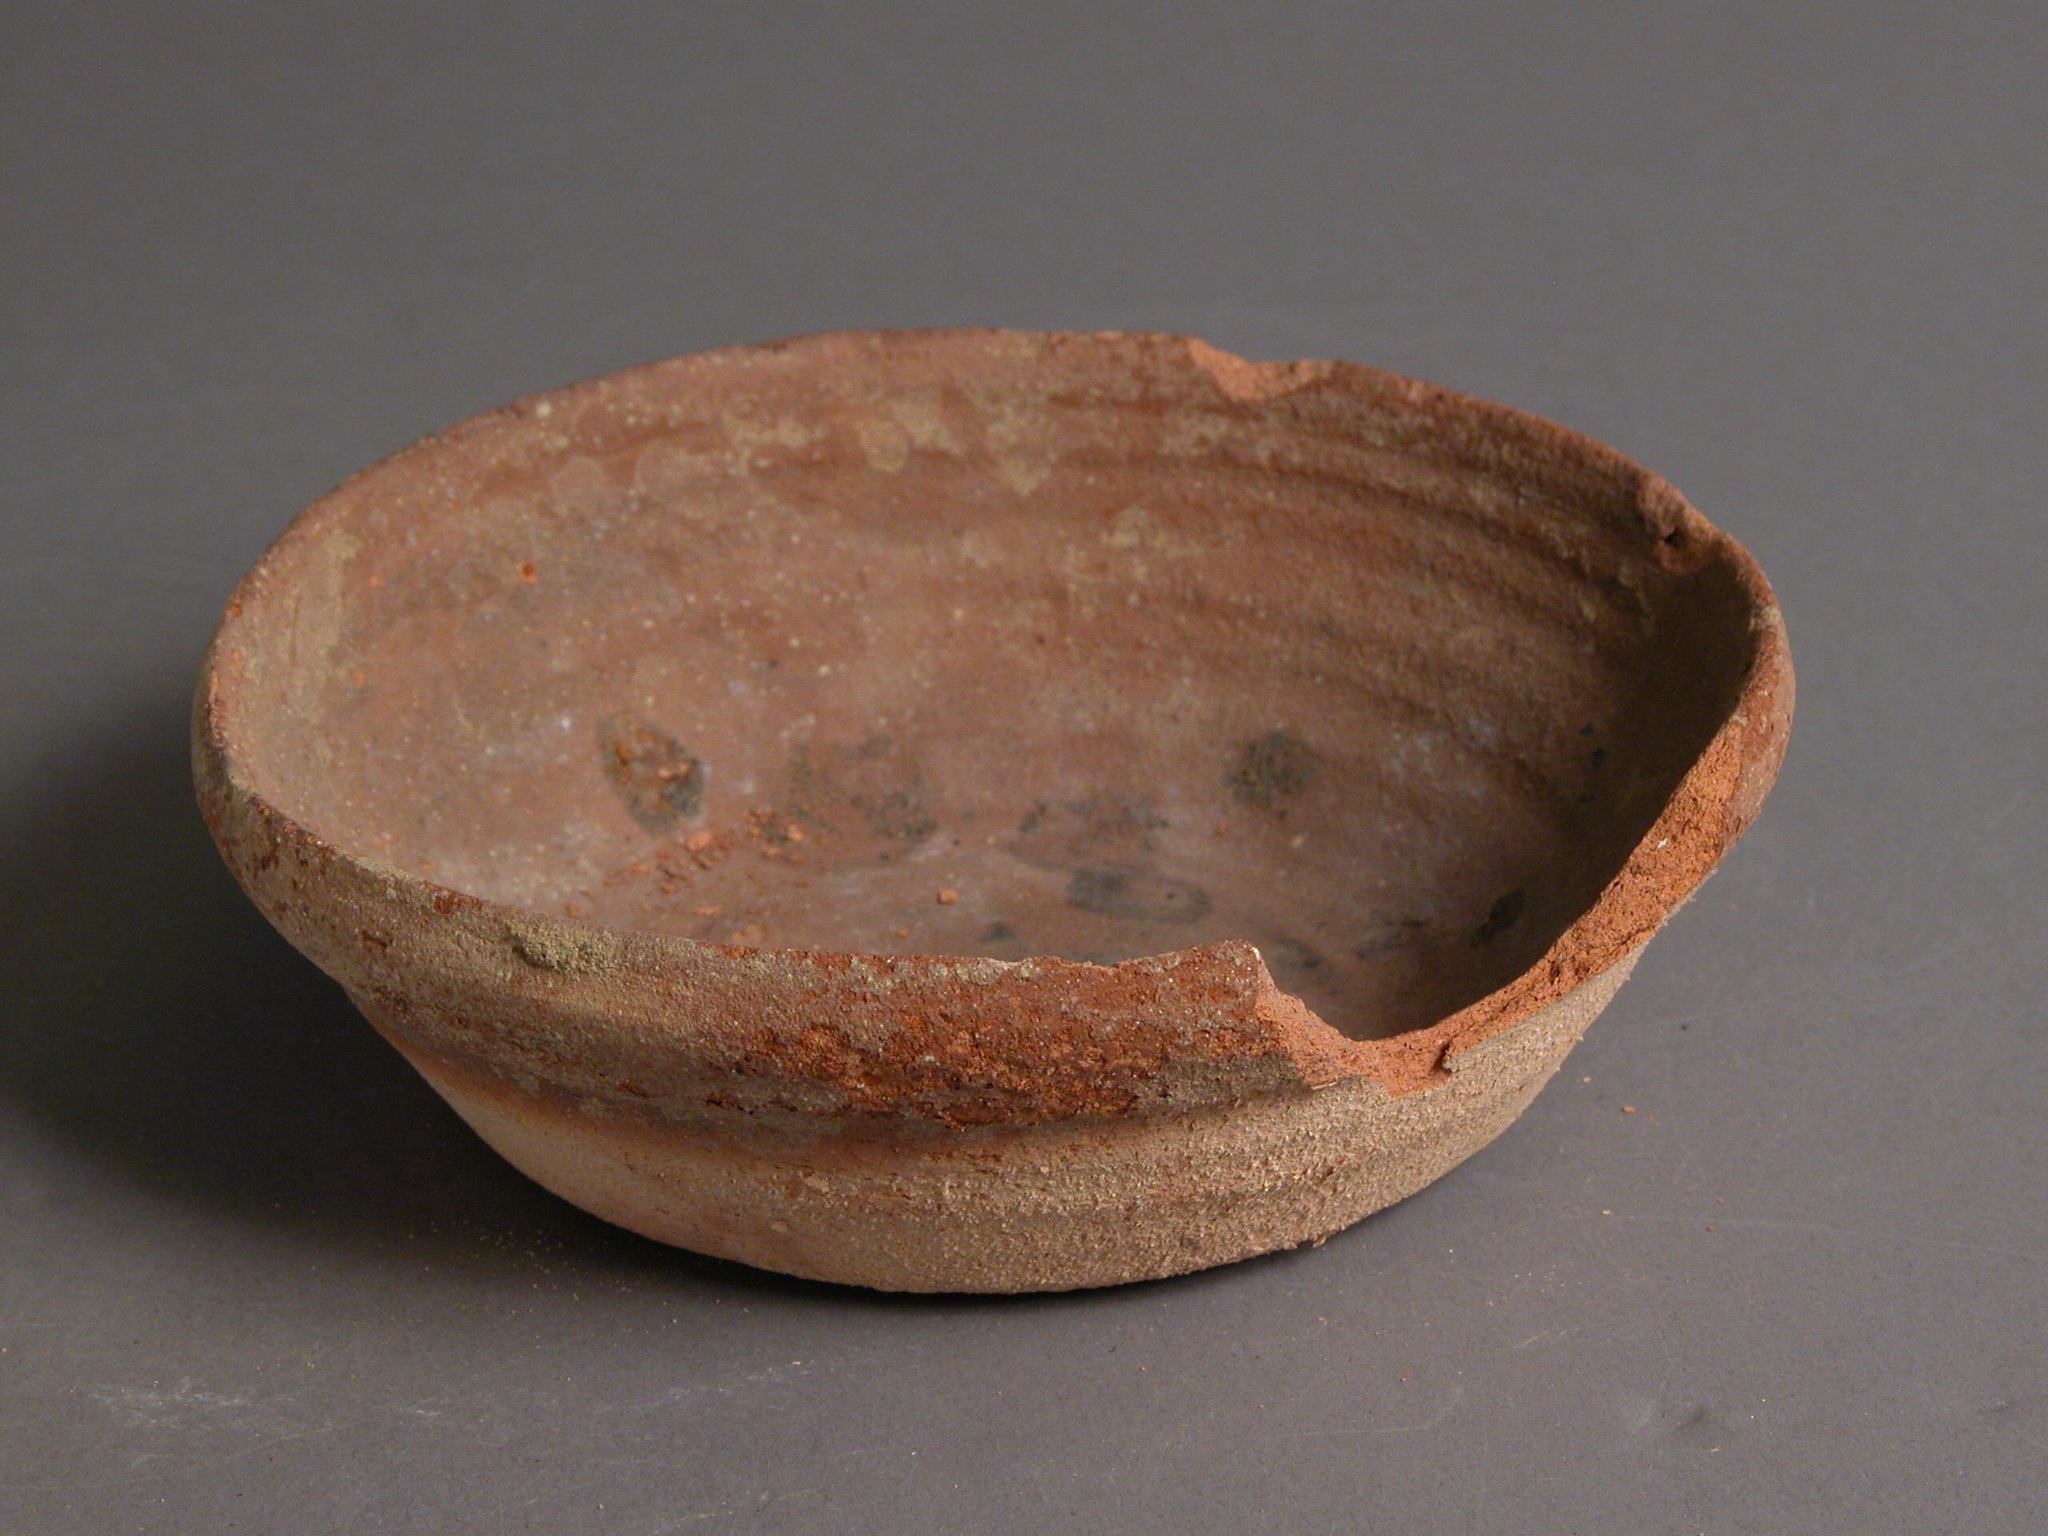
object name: bowl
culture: coptic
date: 301-700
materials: earthenware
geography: egypt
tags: bowls